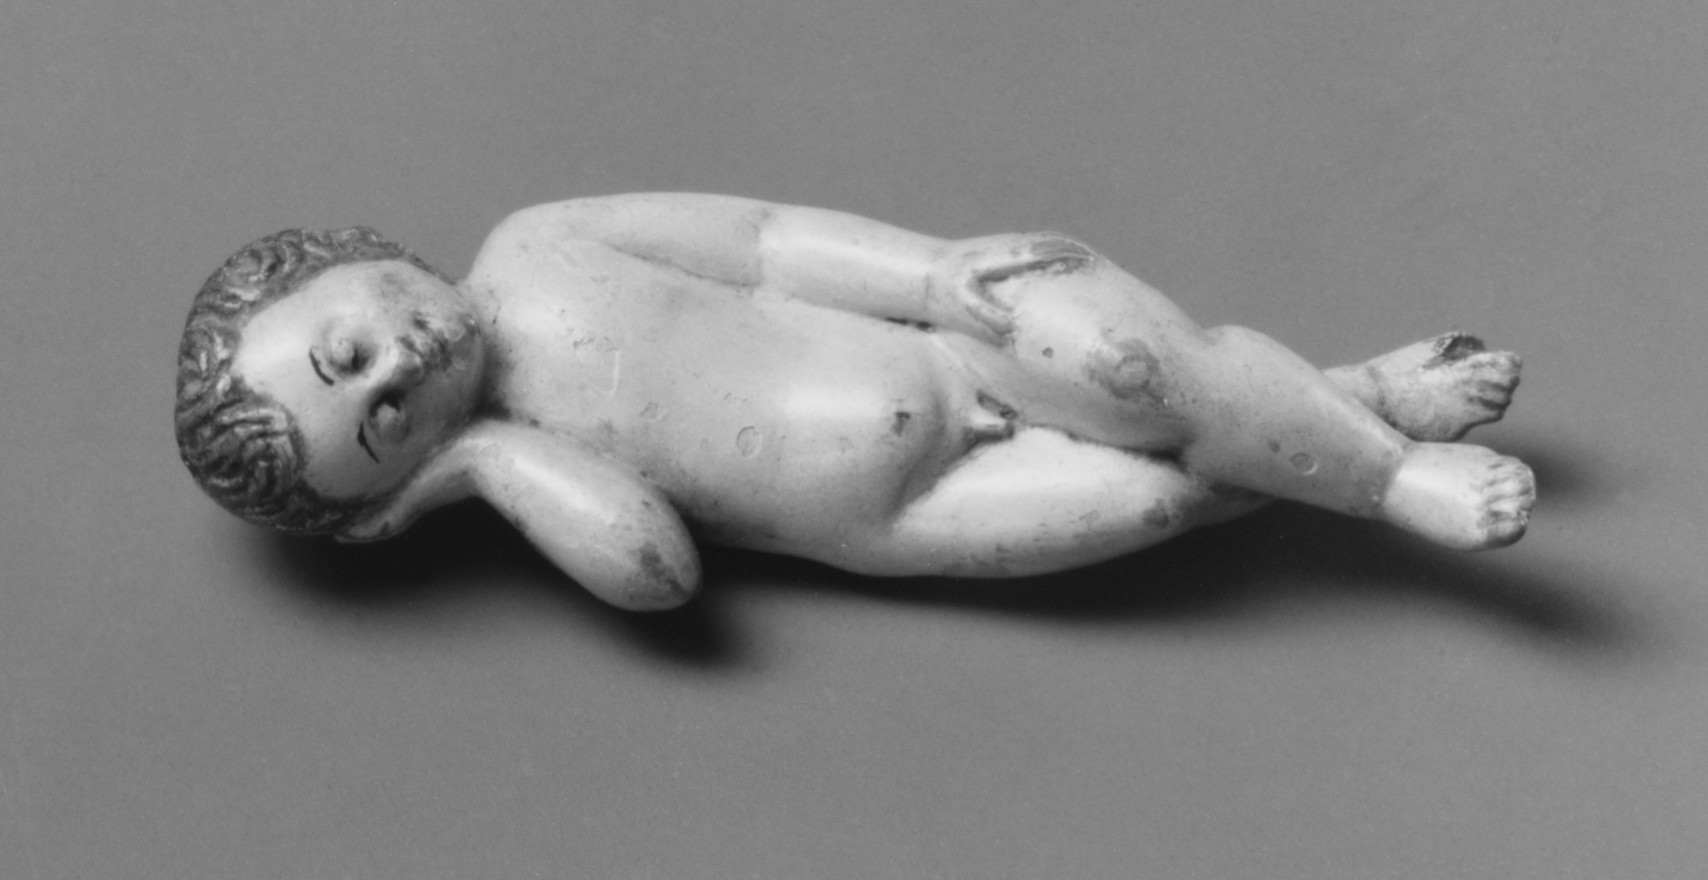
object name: statuette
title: Christ child (from a nativity)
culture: ecuadorian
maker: caspicara (manuel chil)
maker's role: former attribution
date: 1701-1800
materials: glass, wood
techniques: gilding, polychrome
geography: ecuador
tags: infants,christ